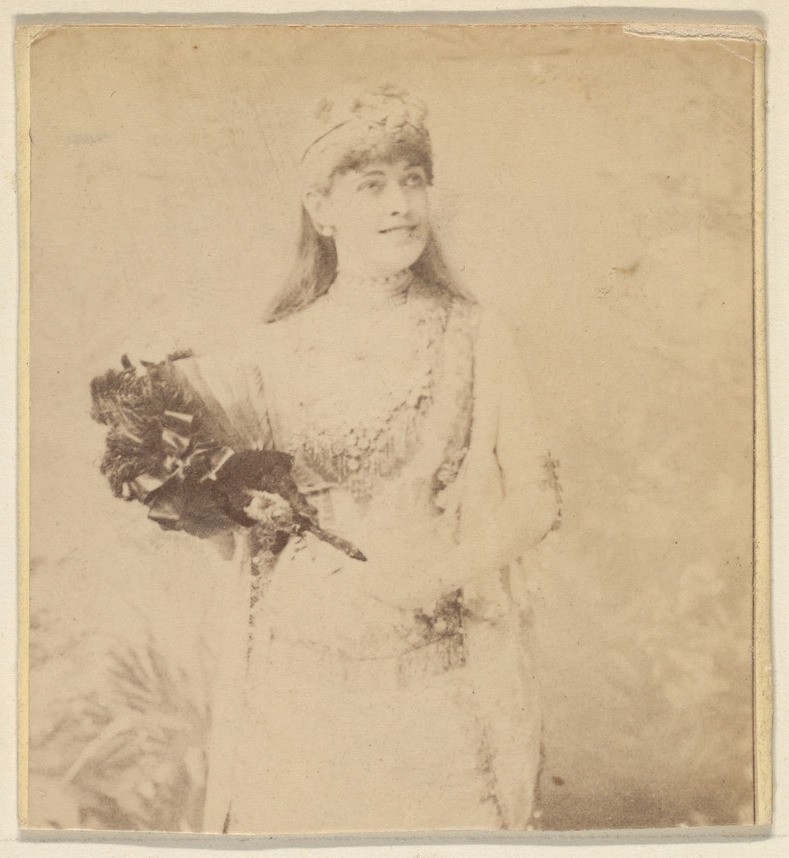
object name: photograph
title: Actress holding bouquet of flowers, from the Actresses series (N246), Type 2, issued by Kinney Brothers to promote Sporting Extra Cigarettes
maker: kinney brothers tobacco company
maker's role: publisher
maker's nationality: american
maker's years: 1869-2011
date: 1890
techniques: albumen silver print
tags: portraits,women,actresses